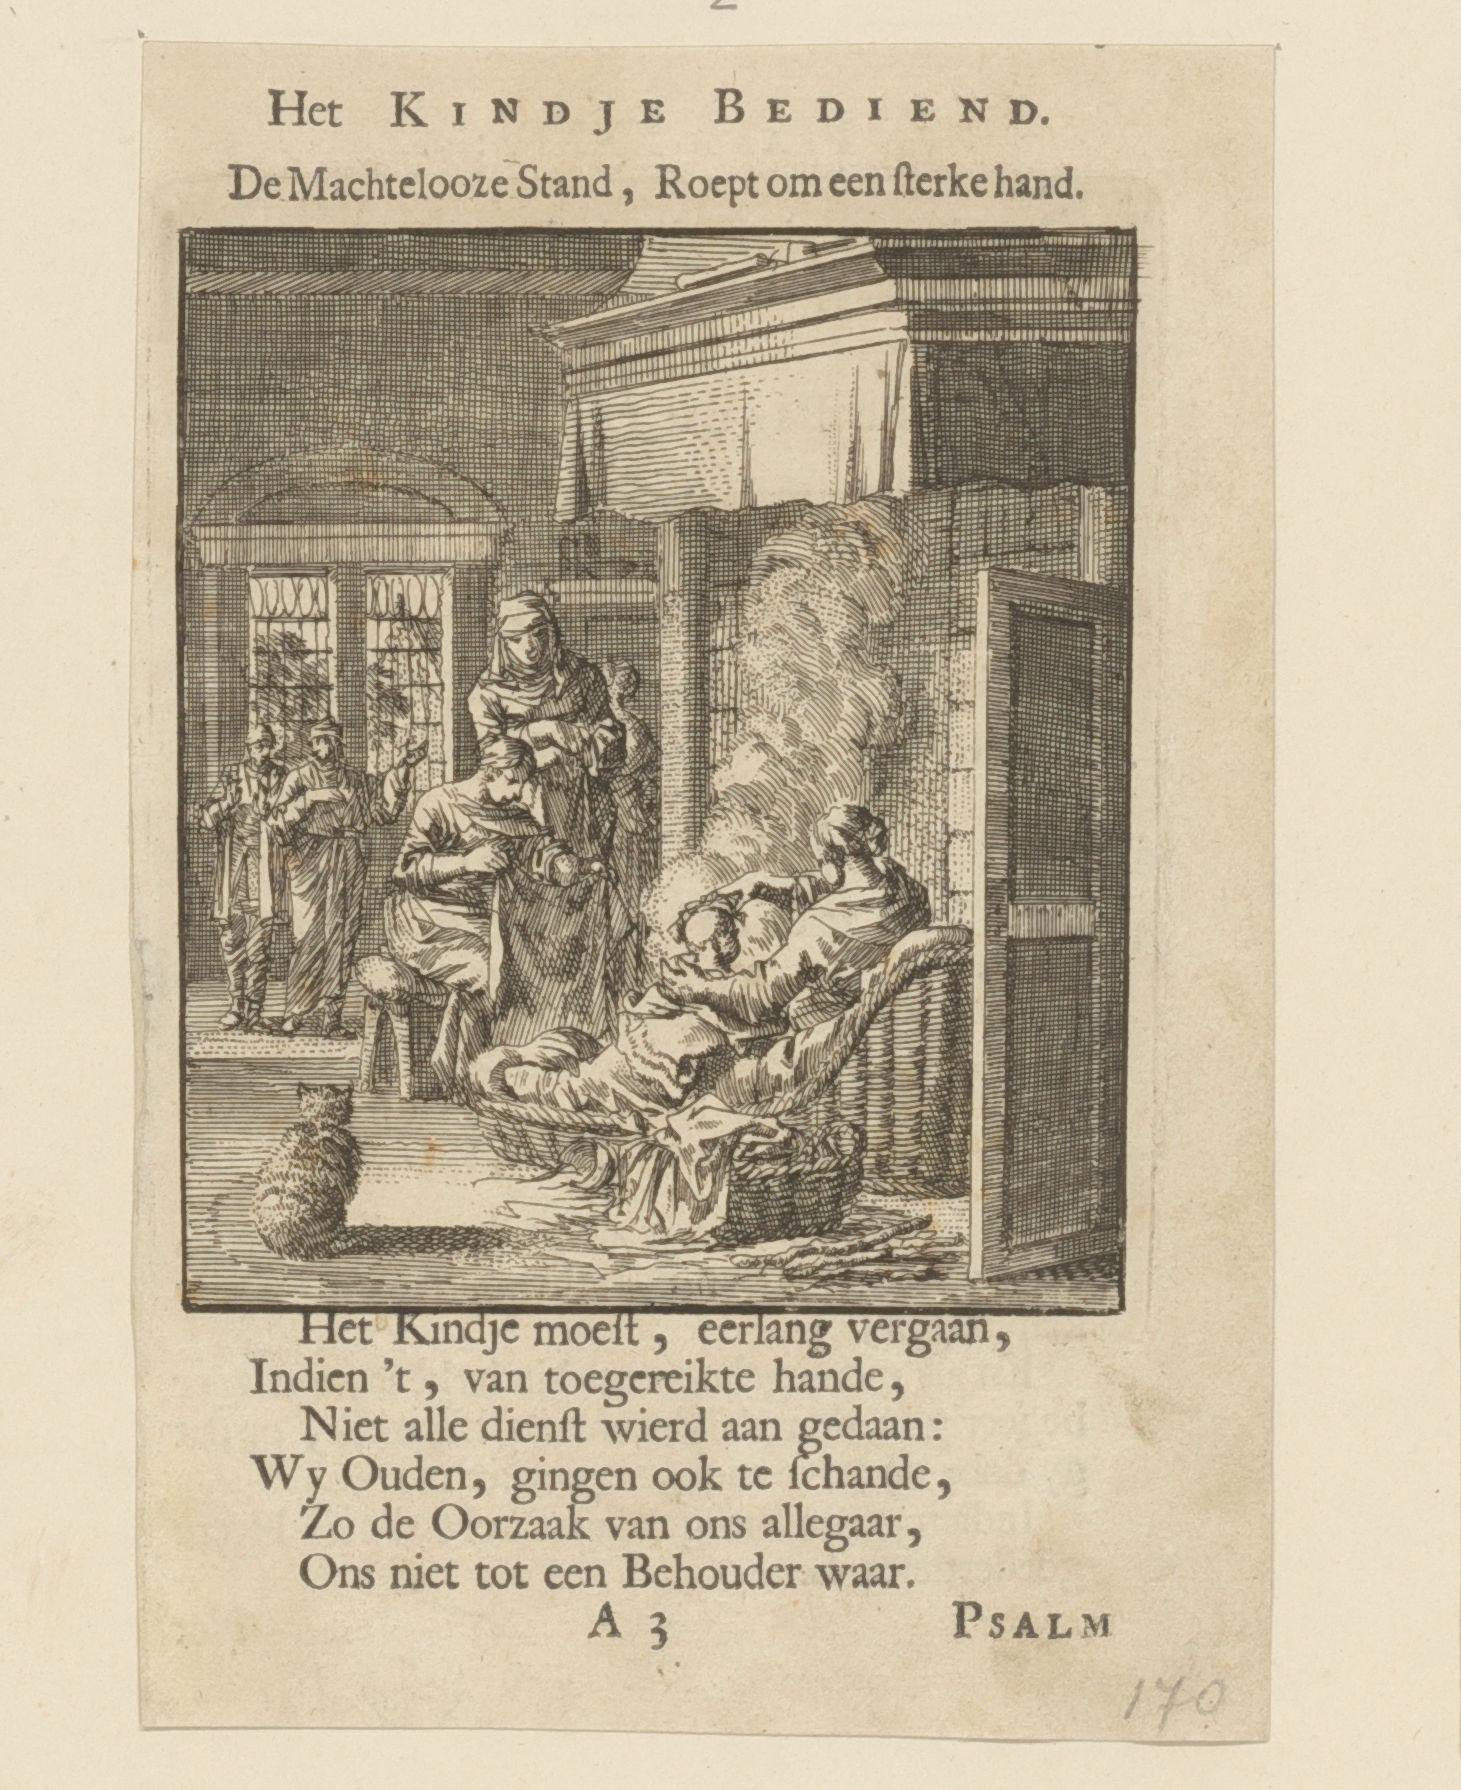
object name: print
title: Kind wordt verzorgd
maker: jan luyken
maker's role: draughtsman, print maker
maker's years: 1649-1712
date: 1712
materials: paper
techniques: etching, letterpress printing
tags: cradle, crib, the new-born child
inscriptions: stamp, stamp, collector's mark: Lugt 1641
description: Onderaan een zesregelig vers. Onderwerpsrubrieken binnen de Atlas Zeden en Gewoonten: Zeden en Gewoonten in Engeren Zin, Des menschen beging, midden en einde, Kinderleven – Kinderspel en Kinderprenten.